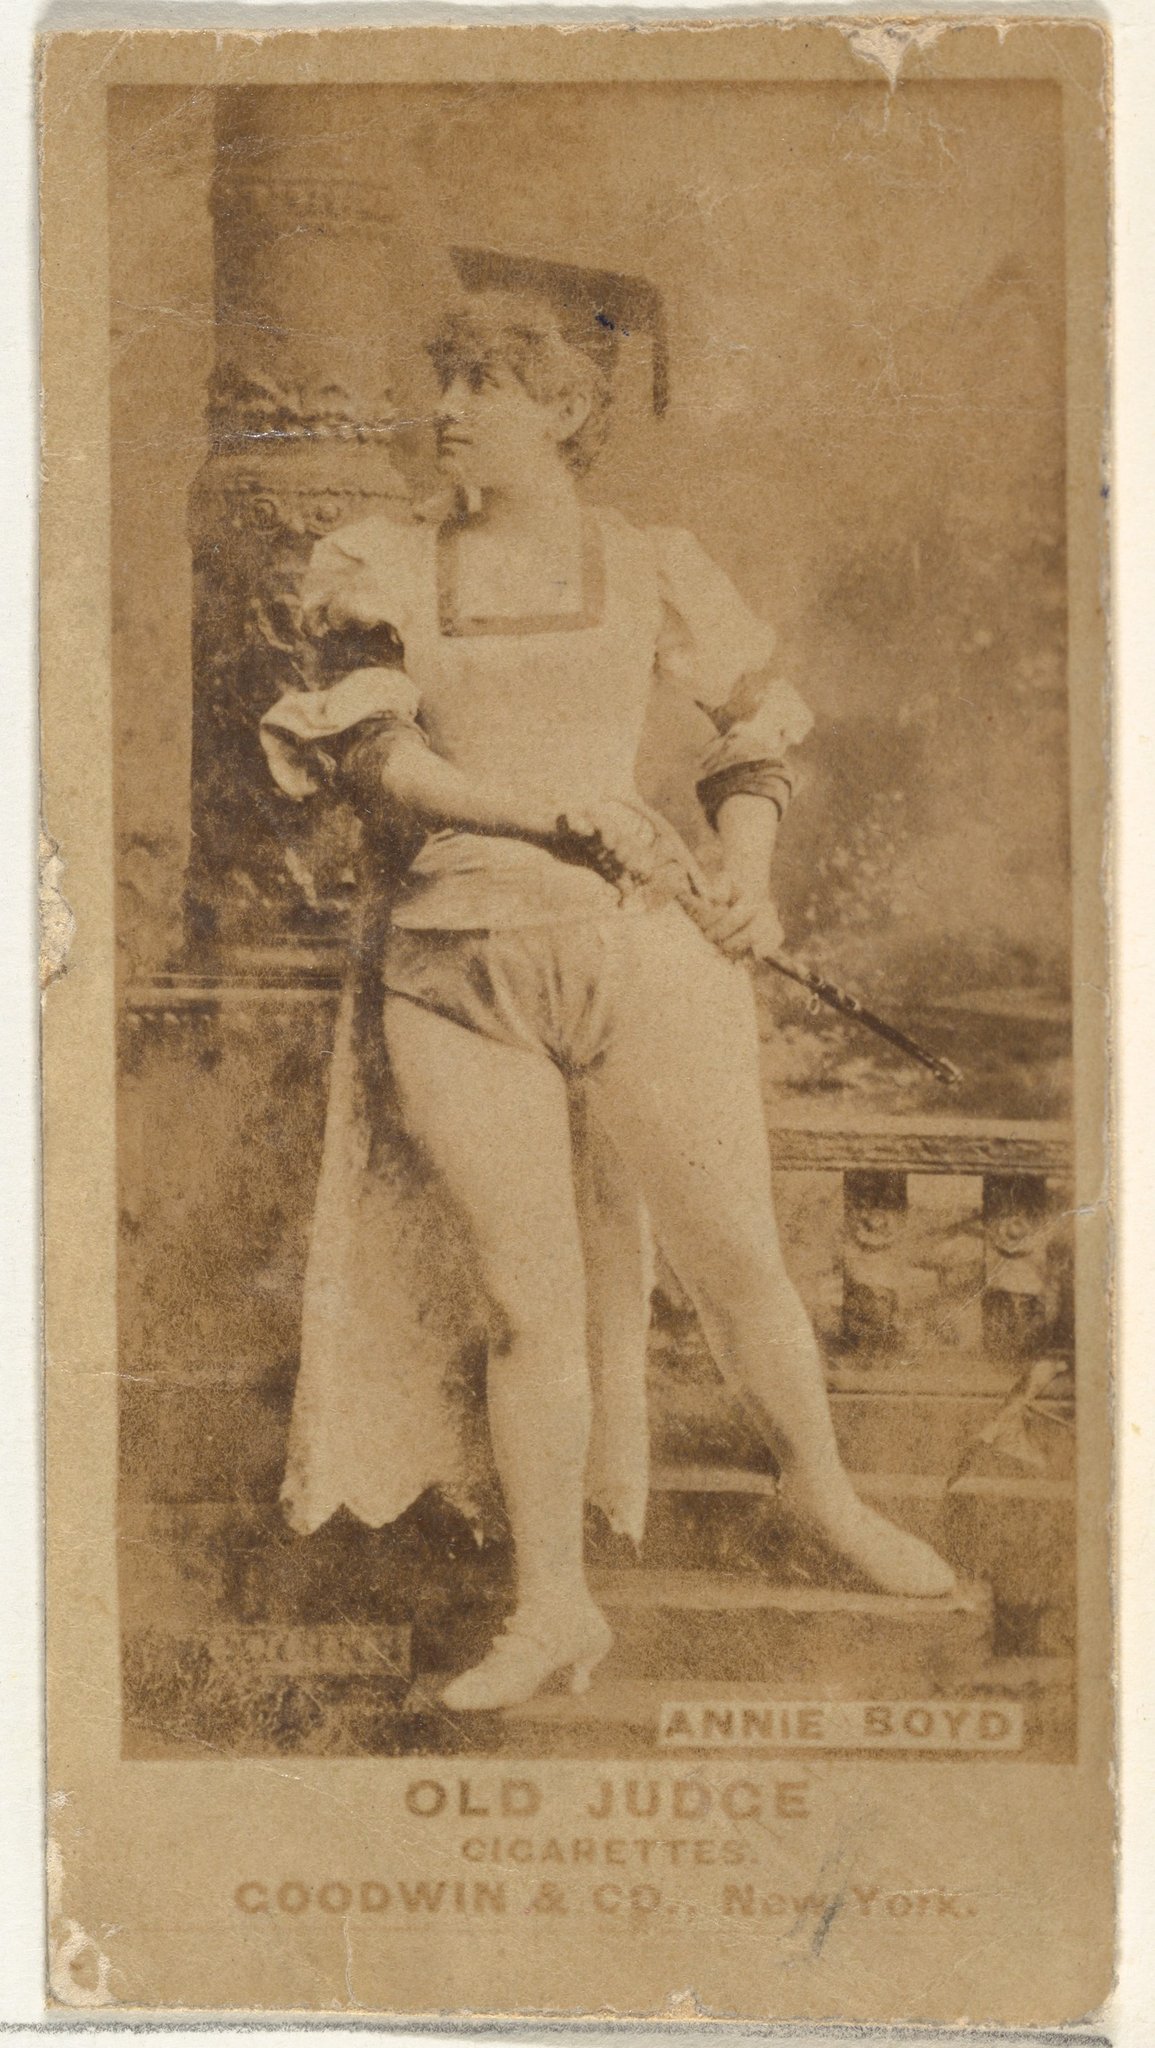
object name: photograph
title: Annie Boyd, from the Actors and Actresses series (N171) for Old Judge Cigarettes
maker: goodwin & company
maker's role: publisher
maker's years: 1850-1950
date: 1886-1890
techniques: albumen silver print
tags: portraits,women,actresses